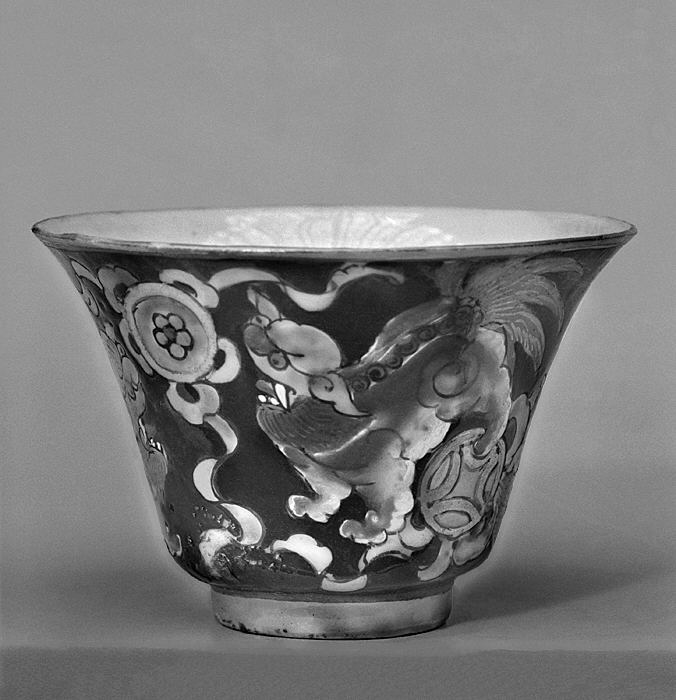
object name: cup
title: Cup with lions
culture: chinese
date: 1801-1900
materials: enamel, porcelain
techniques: overglaze, painting, polychrome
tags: lions